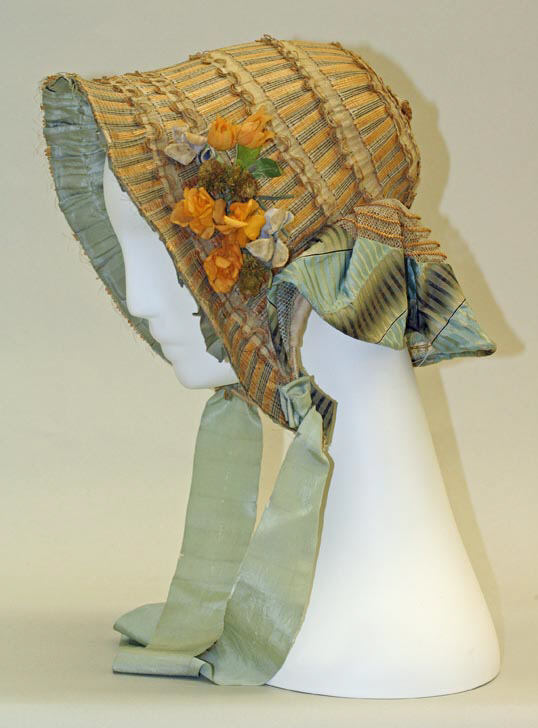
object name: capote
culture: french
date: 1850-1859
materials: hair, fiber